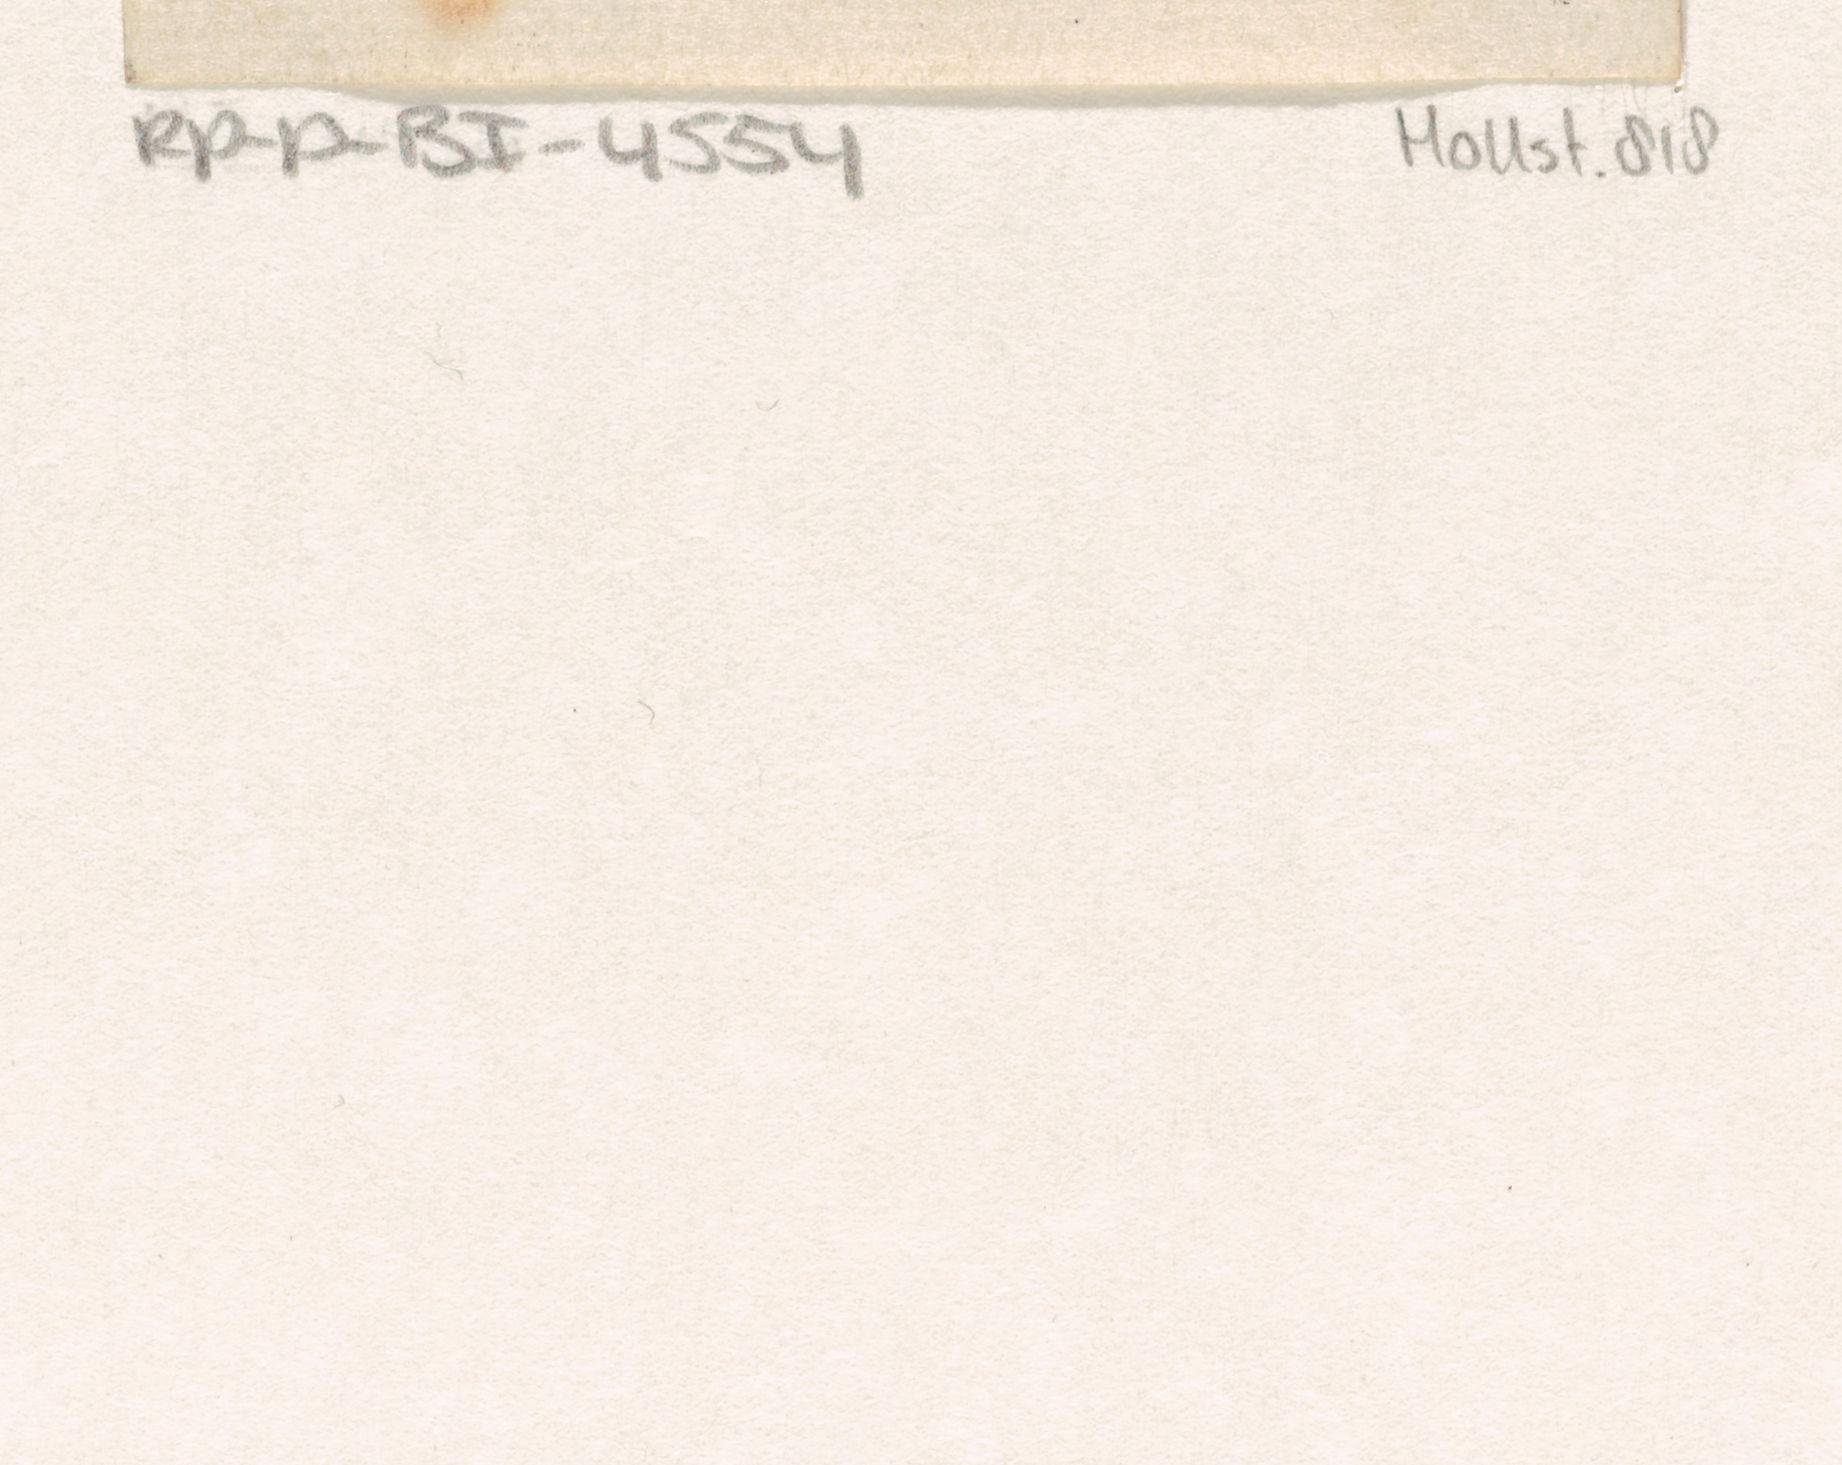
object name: handelsetiket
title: Handelsetiket van Hendrick Witte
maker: isaac vincentsz. van der vinne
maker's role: draughtsman, print maker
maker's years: 1665-1740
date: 1681-1740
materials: paper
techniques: woodcut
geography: haarlem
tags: coat of arms (as symbol of the state, etc.) (+ city; municipal), vignette, letter combinations such as letterword, anagram, letter square, monogram, etc., haarlem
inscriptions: collector's mark: Lugt 240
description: Een handelsmerk van Hendrick Witte in een ovaal met randschrift. Midden onder het wapen van de stad Haarlem.